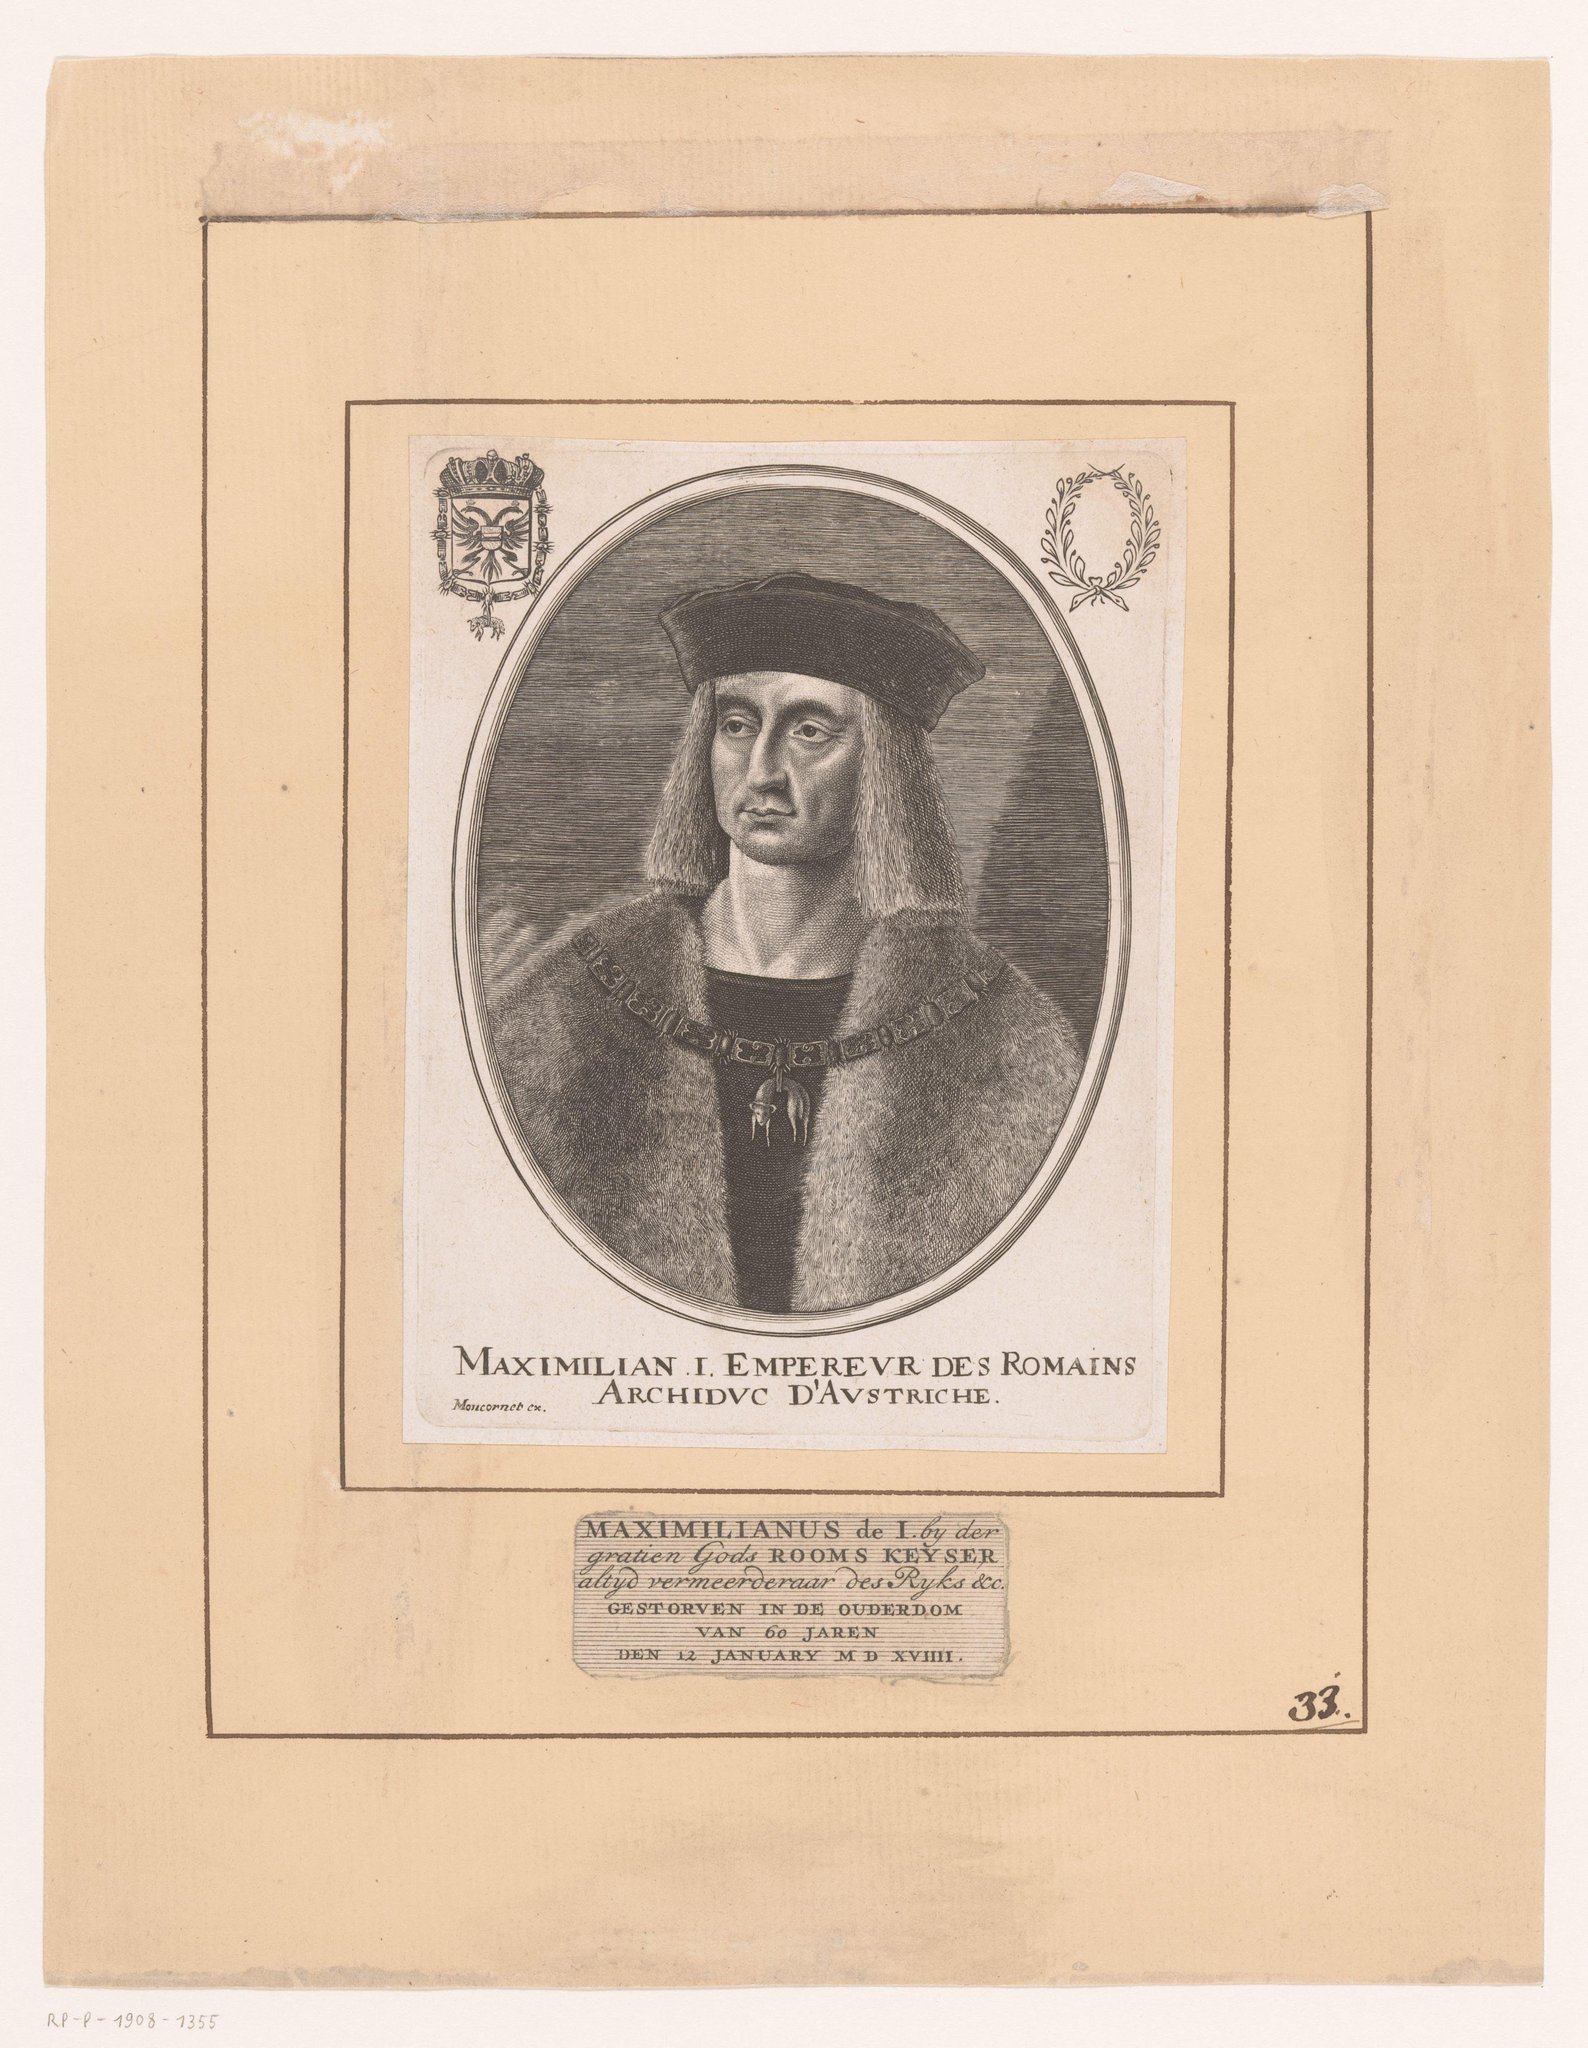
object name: print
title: Portret van keizer Maximiliaan I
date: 1610-1668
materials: paper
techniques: engraving, letterpress printing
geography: paris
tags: maximilian i (holy roman emperor), historical persons, emperor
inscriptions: collector's mark: Lugt 2228